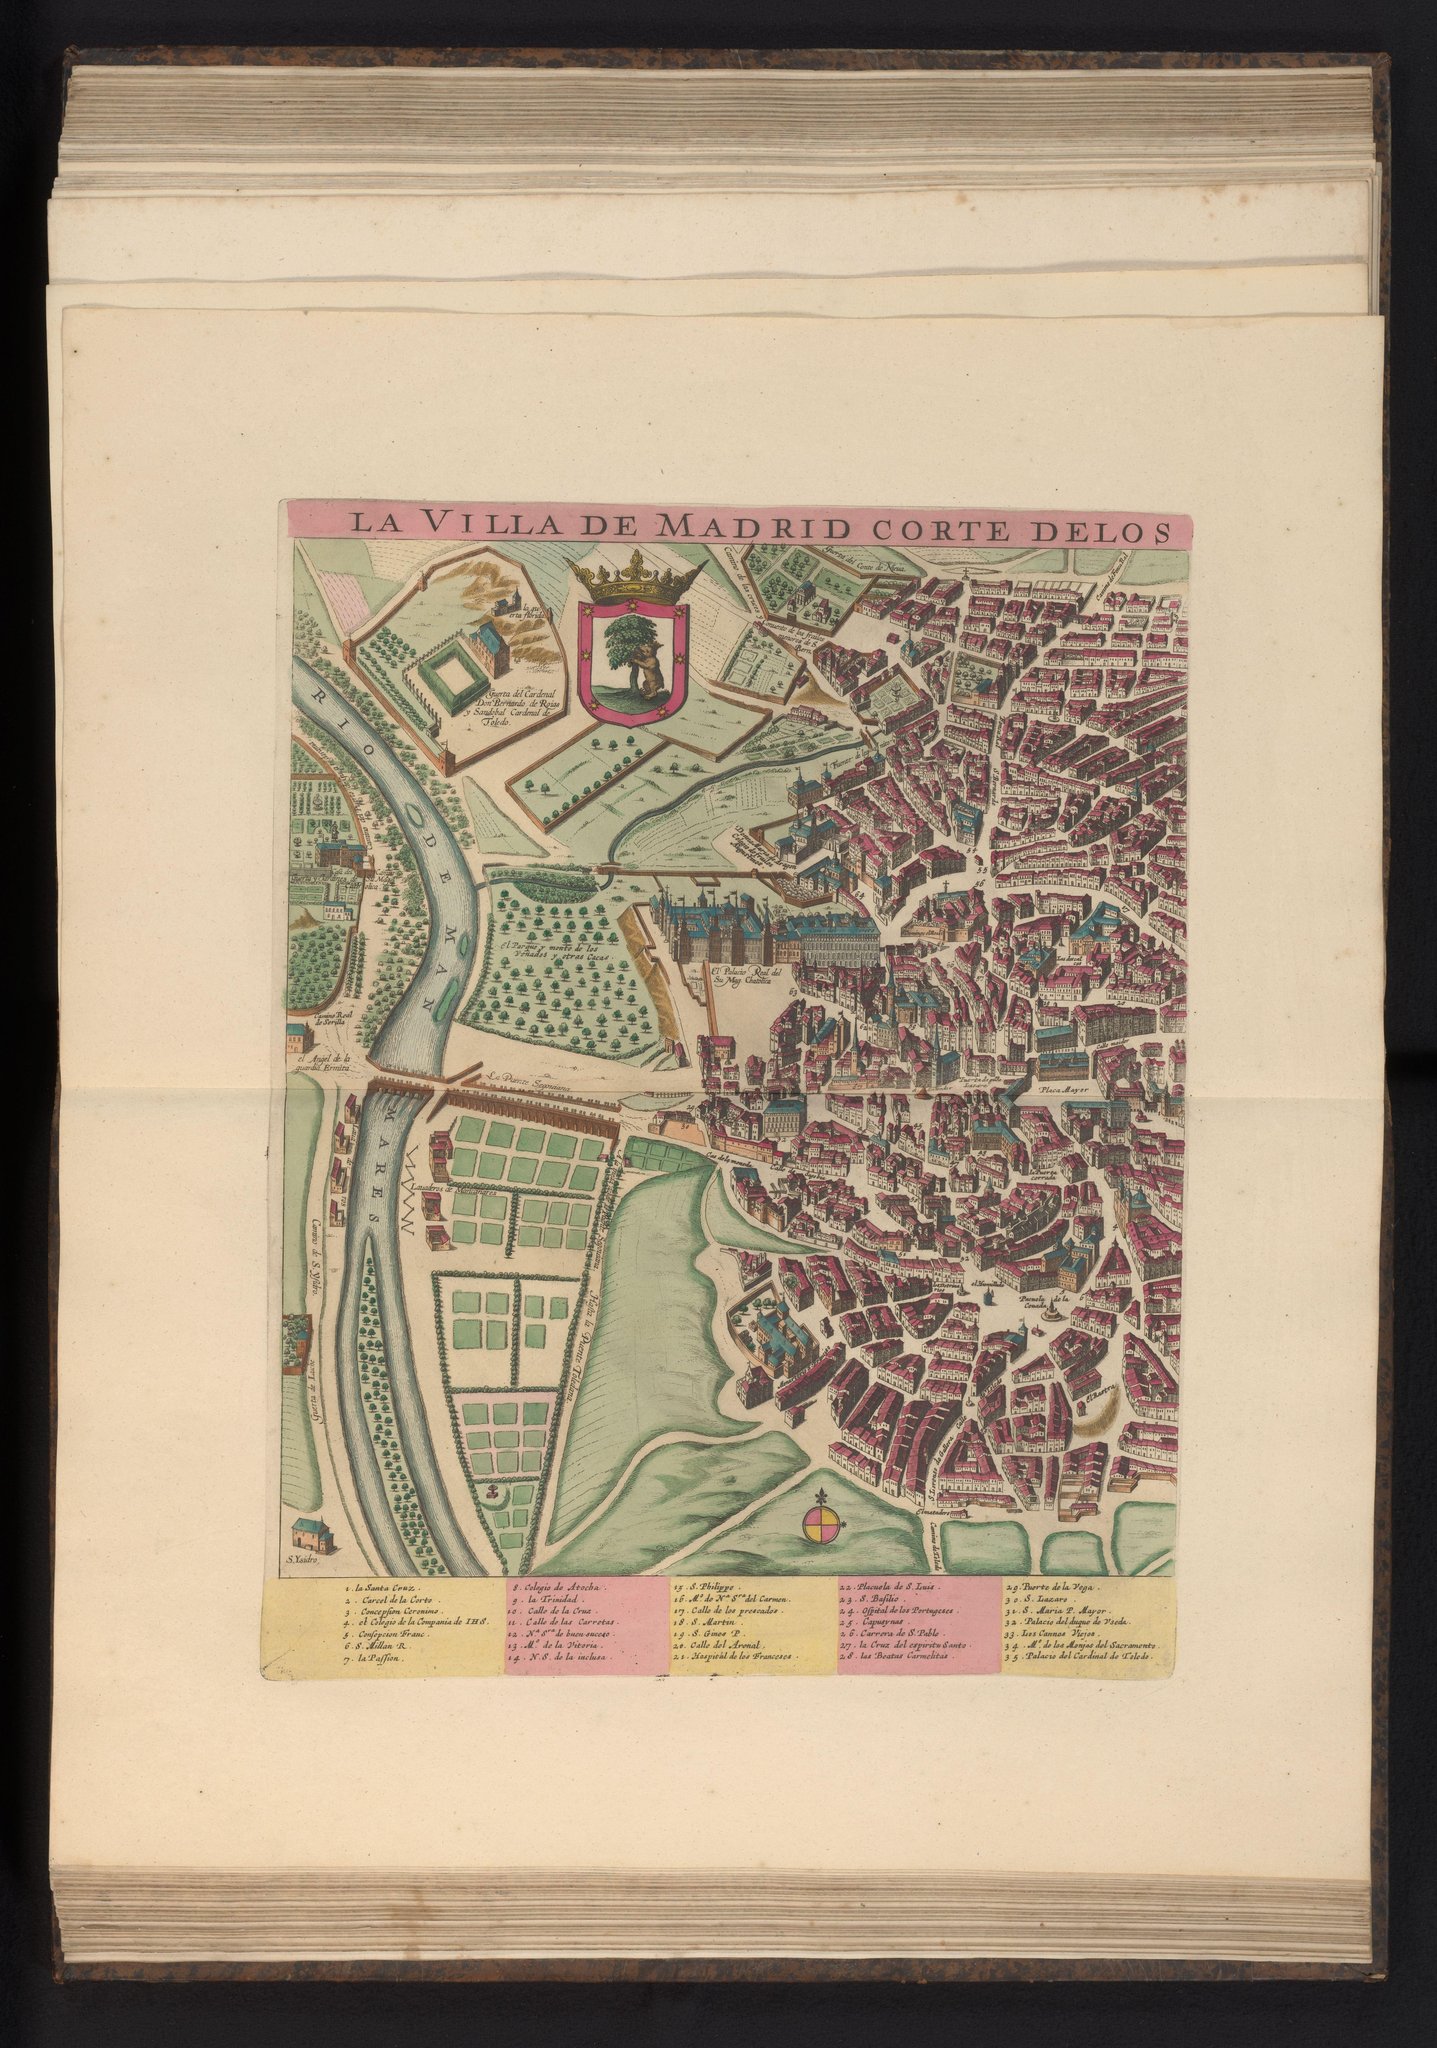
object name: print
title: Plattegrond van Madrid, linkerdeel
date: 1640-1706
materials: paper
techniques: engraving, etching, hand coloring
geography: amsterdam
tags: maps of cities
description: Linkerdeel van een kaart van de stad Madrid gezien in vogelvluchtperspectief. Prent maakt deel uit van een album.